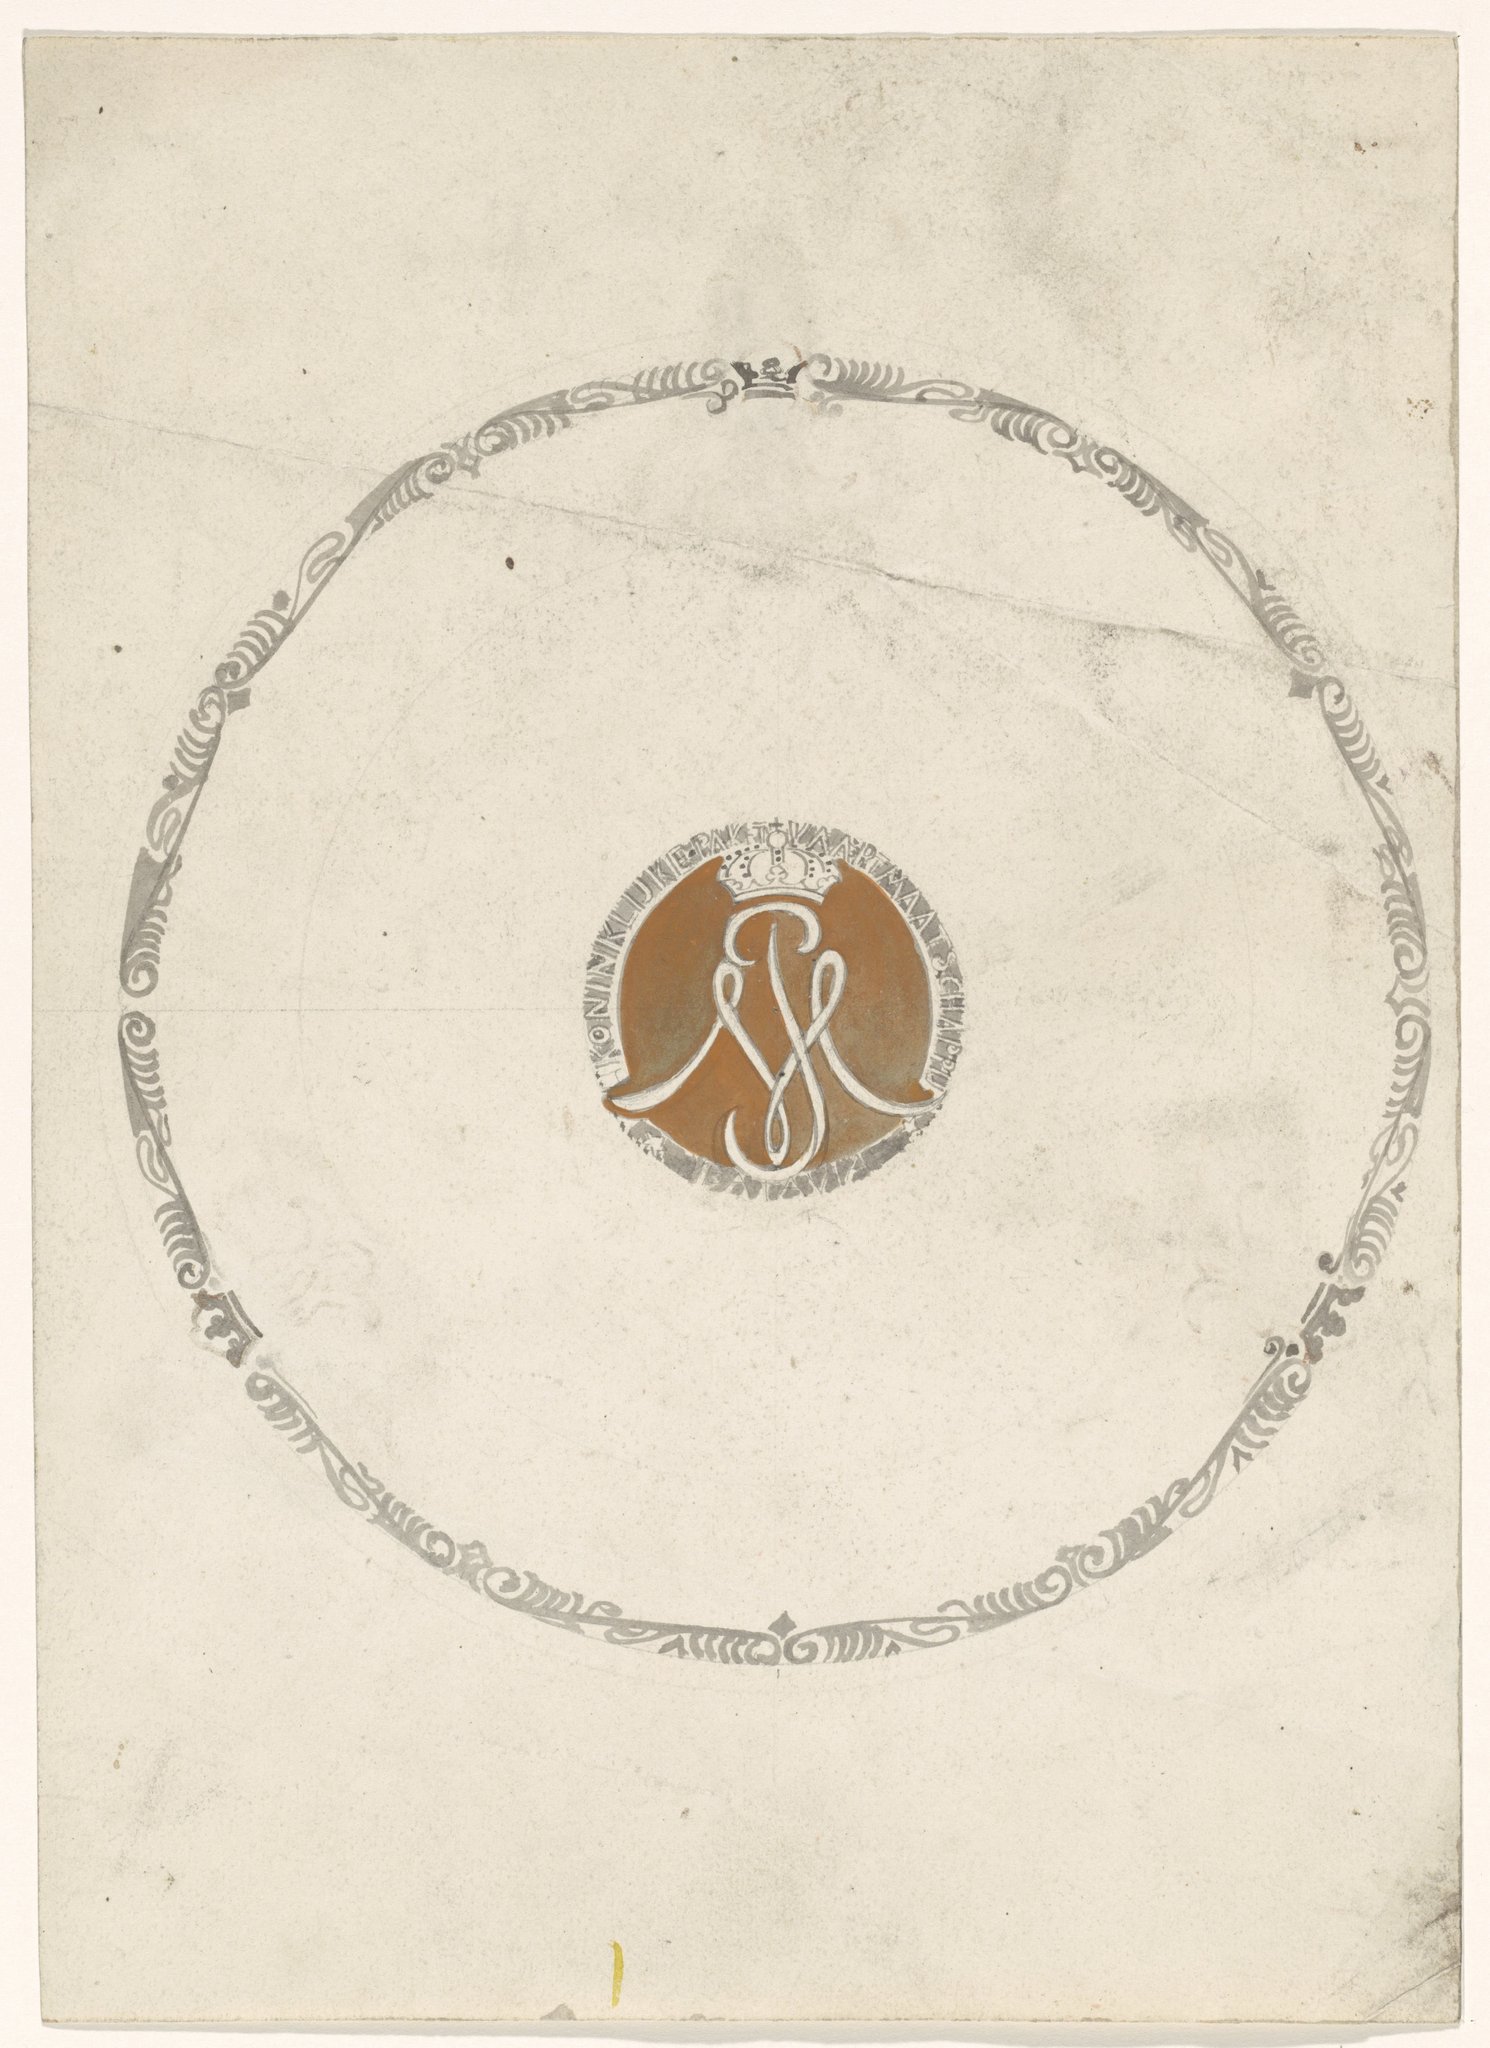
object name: drawing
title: Ontwerp voor een bord voor de Koninklijke Paketvaart Maatschappij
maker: carel adolph lion cachet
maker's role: draughtsman, print maker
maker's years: 1864-1945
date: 1874-1945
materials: ink, paper, pencil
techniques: brush, pen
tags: work of applied art (+ ceramics ~ arts), names of organizations, companies, trade unions, etc., (other) historical names, dish, plate, saucer, batavia, indonesia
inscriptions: inscription: ‘Batavia’